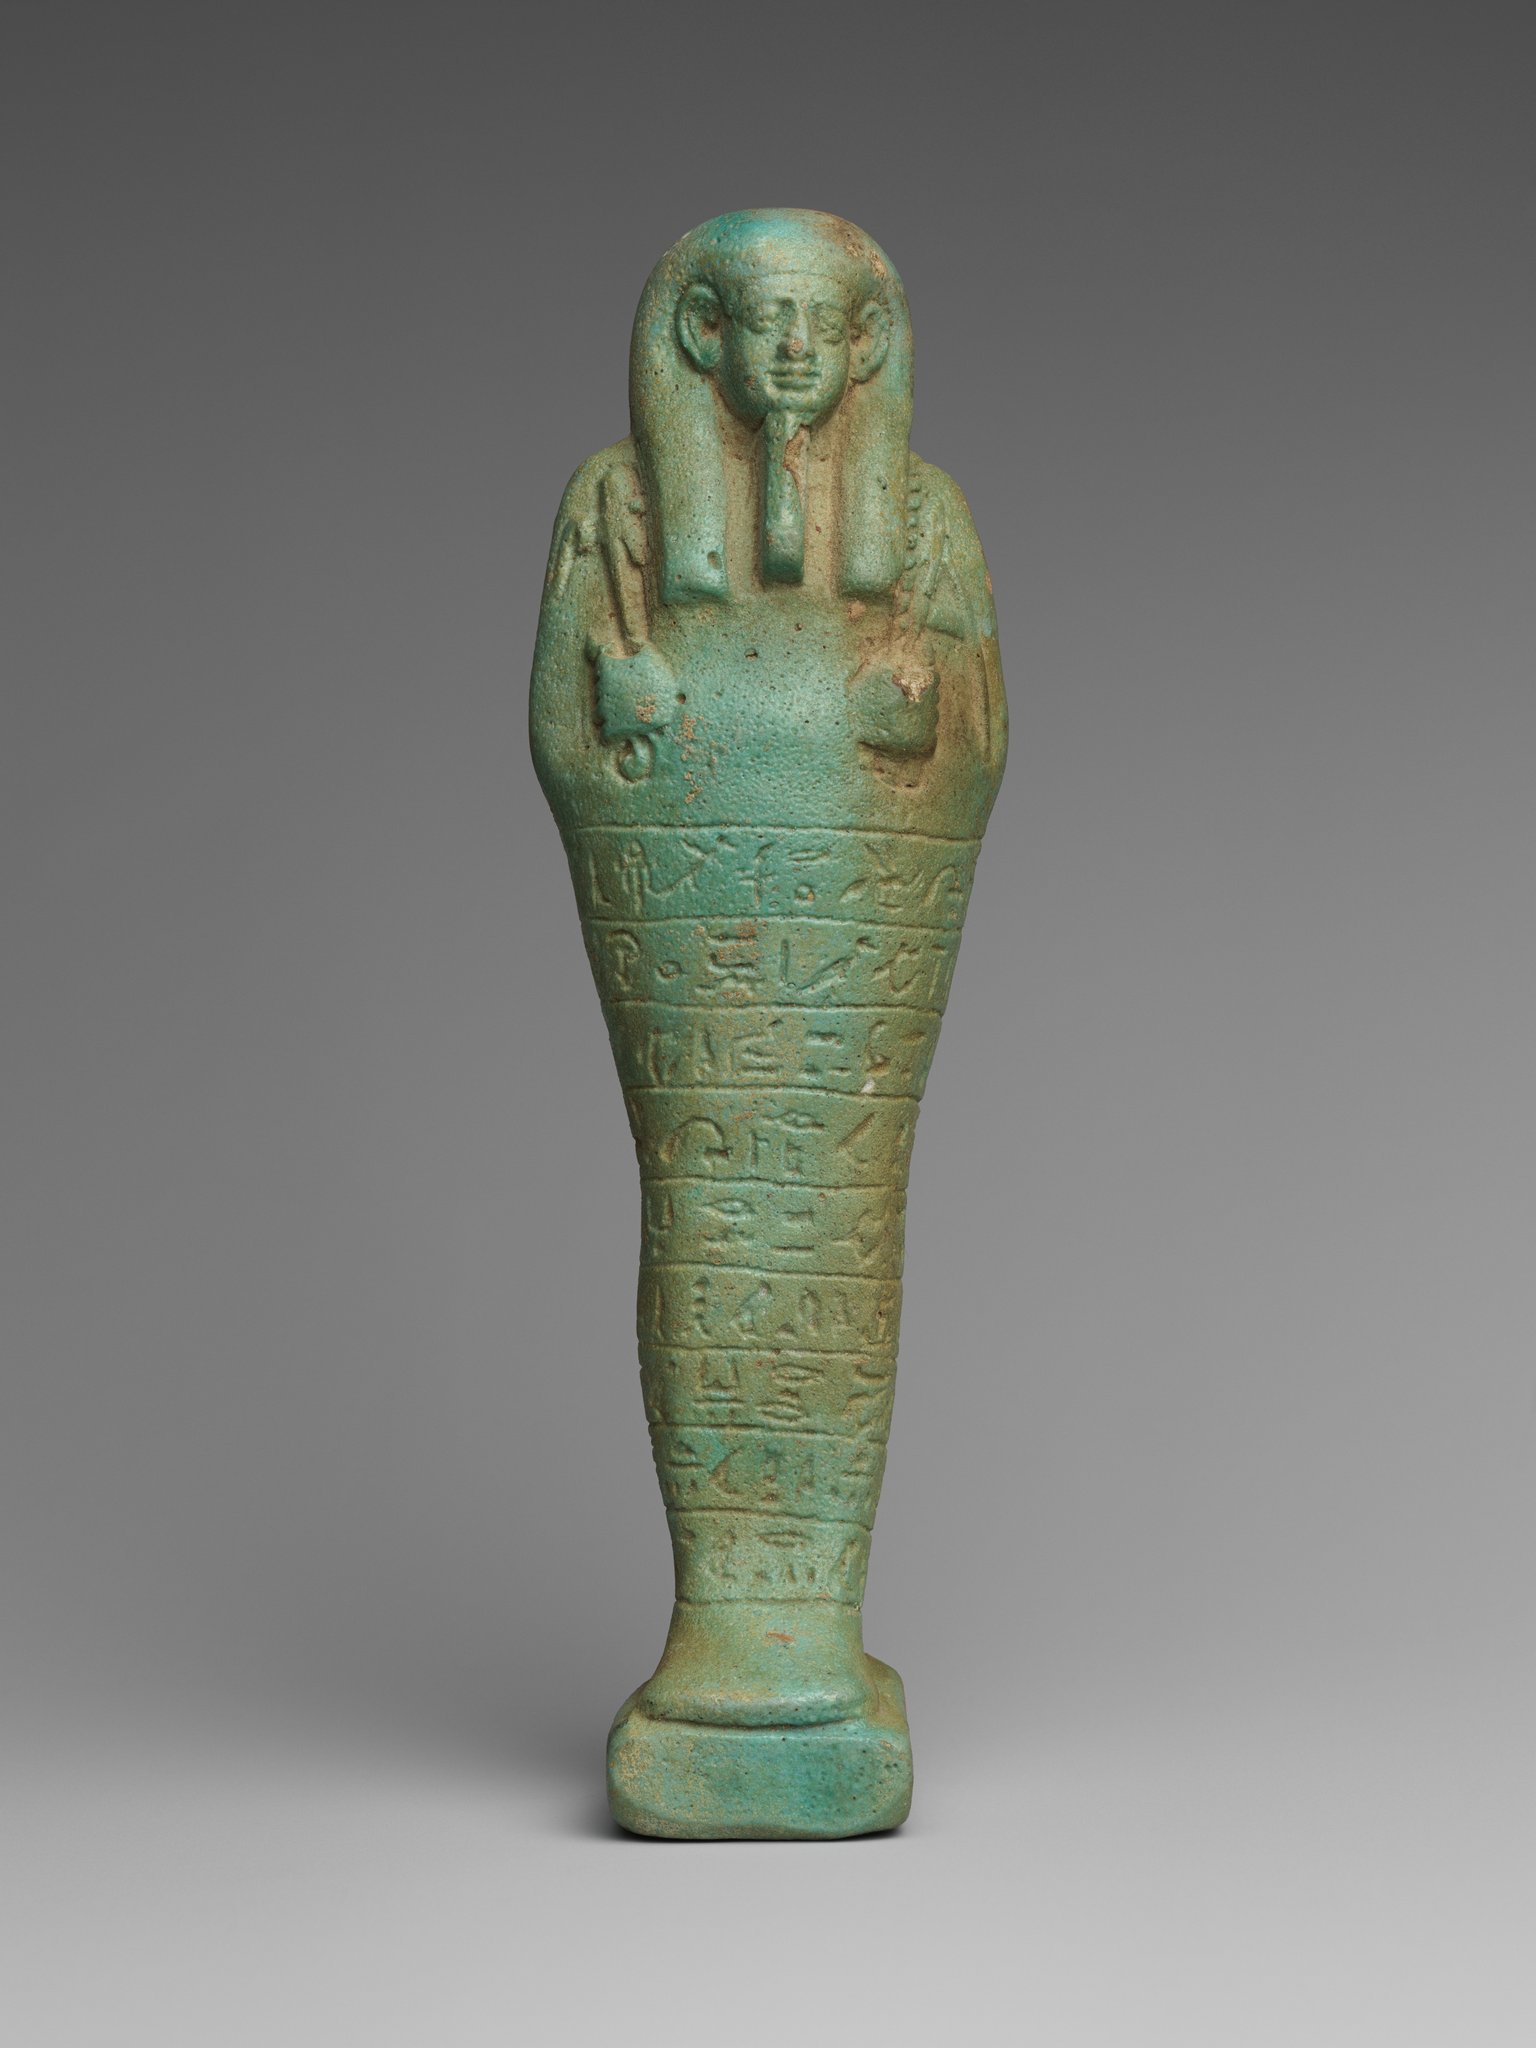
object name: shabti, pa abu meh, psamtik seneb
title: Shabti of the Treasurer of Lower Egypt Pa-abumeh, called Psamtik-seneb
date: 595-380 BCE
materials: faience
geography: egypt